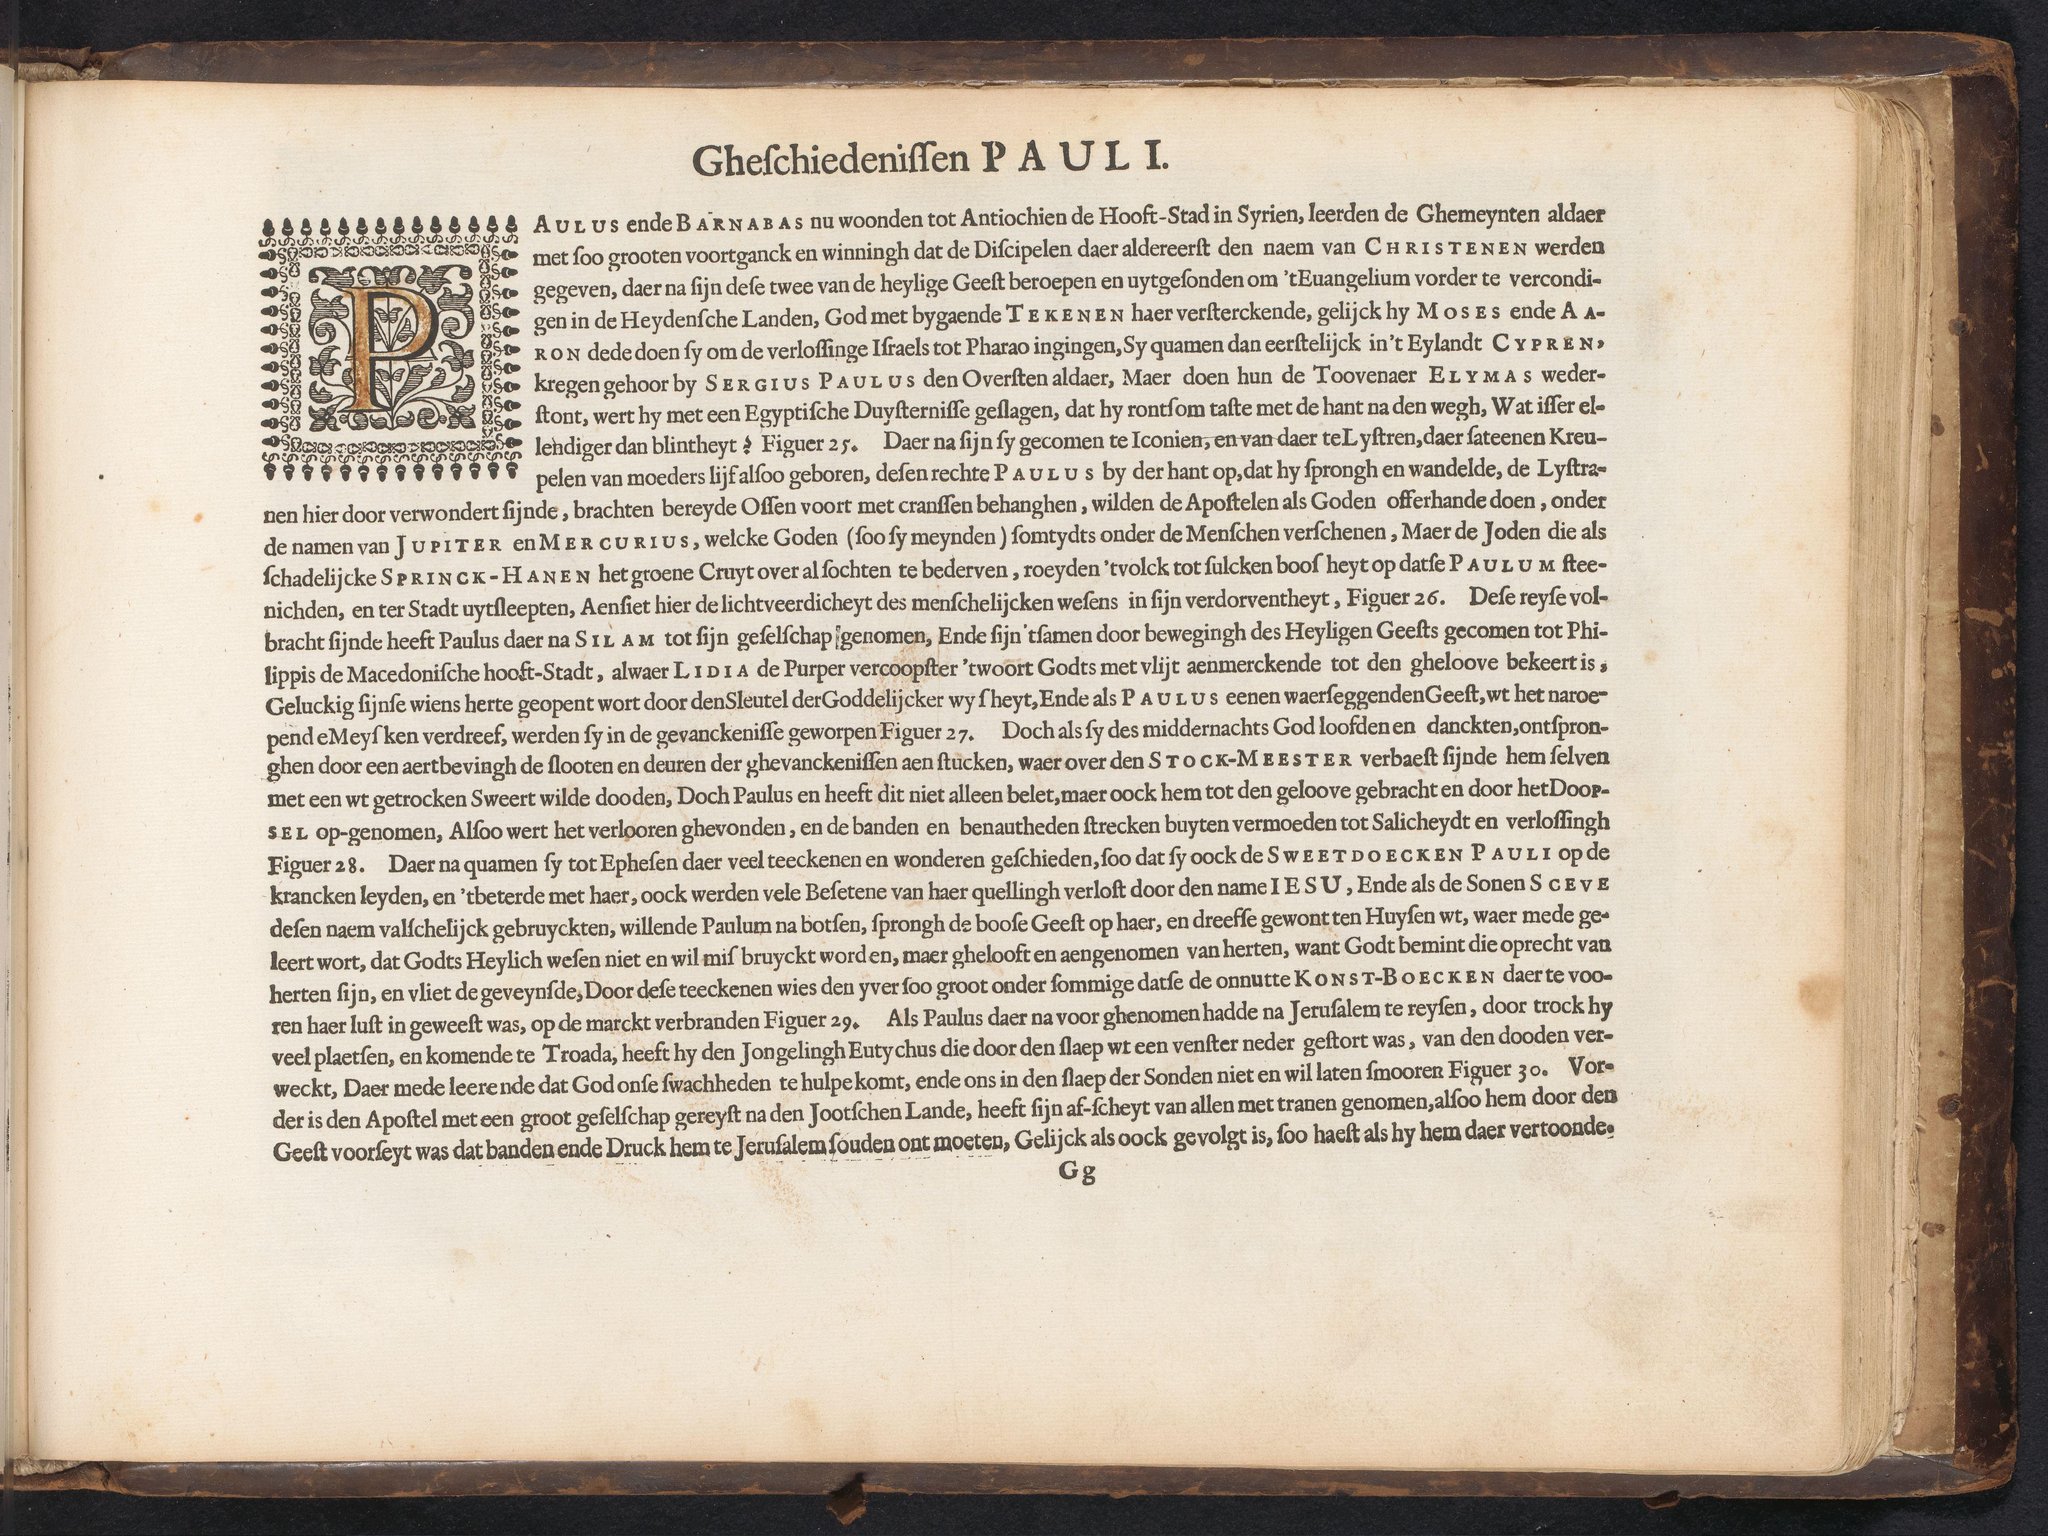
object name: text sheet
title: Den Grooten Figuer-Bibel (...)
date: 1646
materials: paper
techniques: hand coloring, letterpress printing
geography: alkmaar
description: Tekstblad bij een serie prenten over de geschiedenis van Paulus. Linksboven initiaal P. Dit blad maakt deel uit van een album.